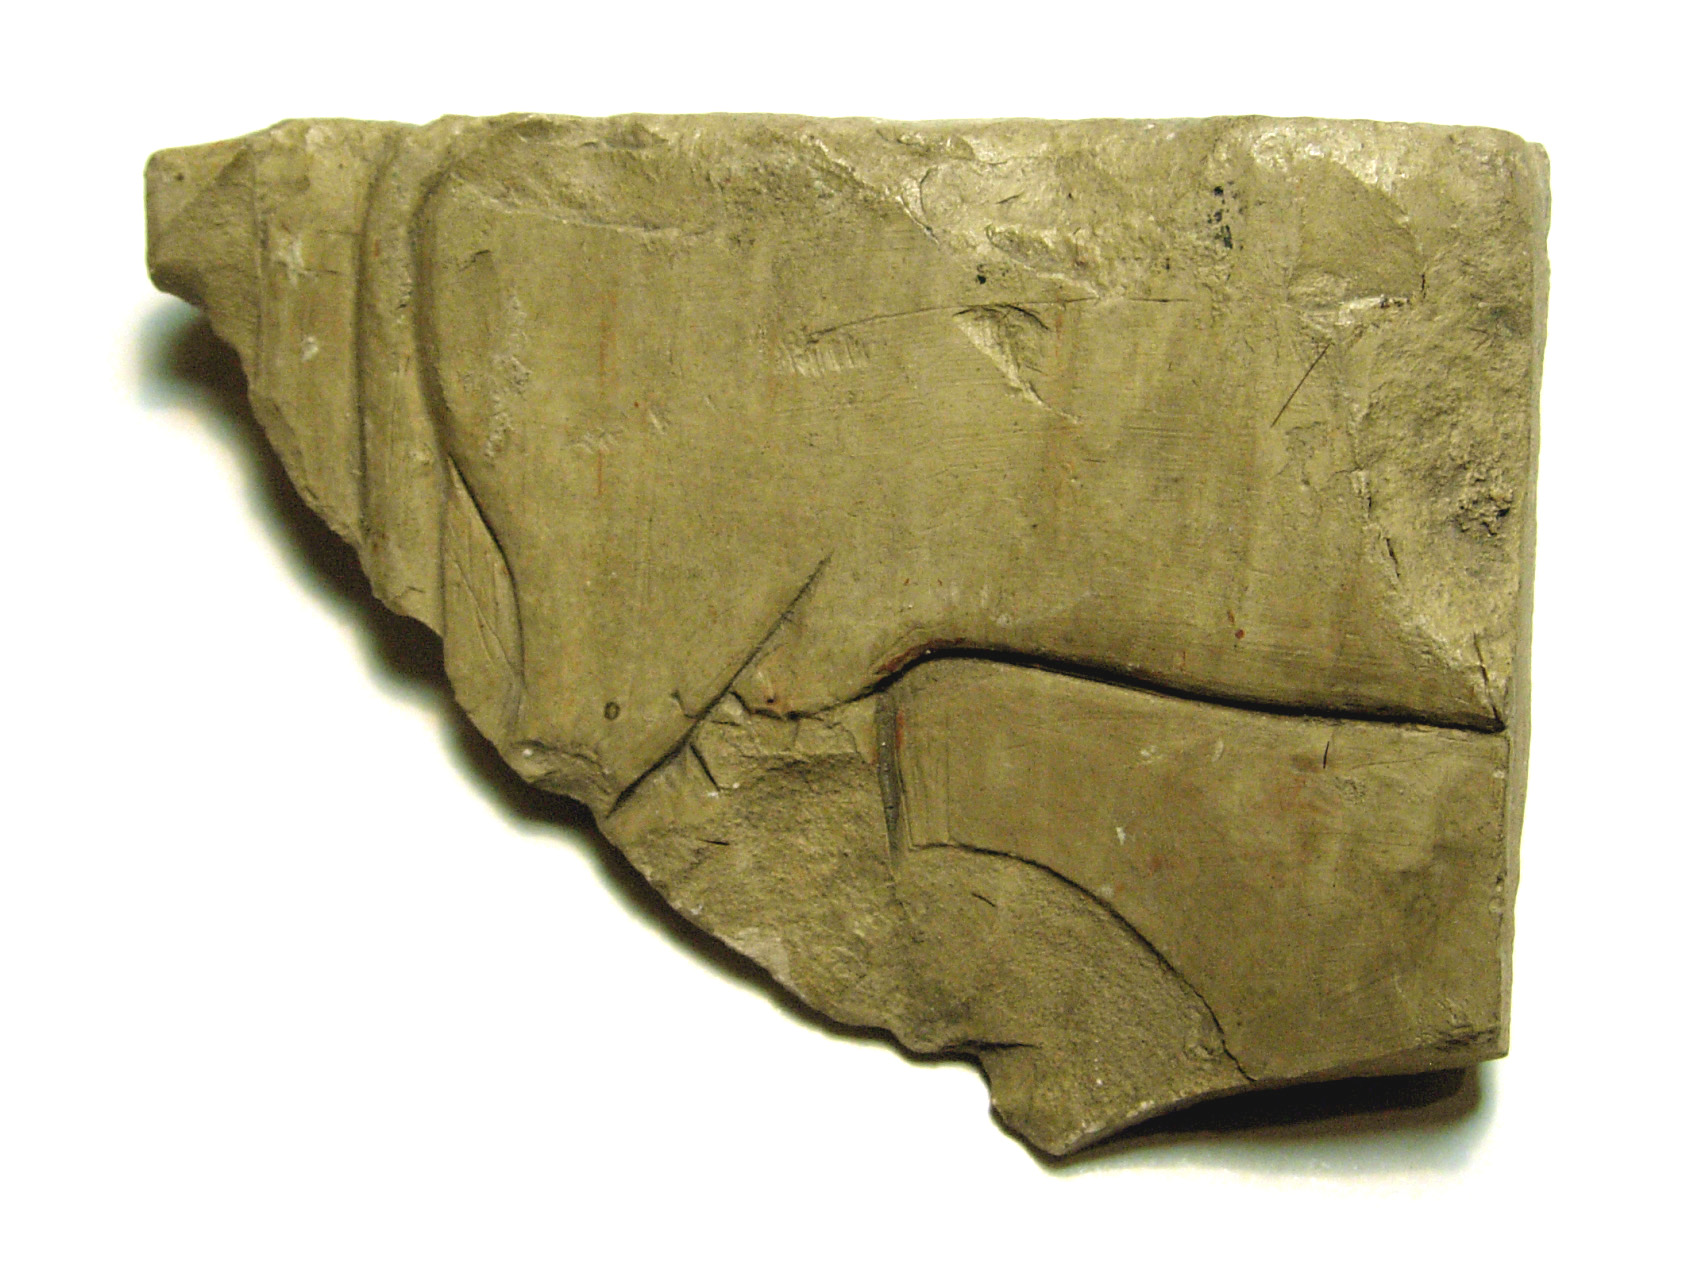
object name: relief, tomb of nespekashuty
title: Raised relief fragment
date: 664-610 BCE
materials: limestone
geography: egypt